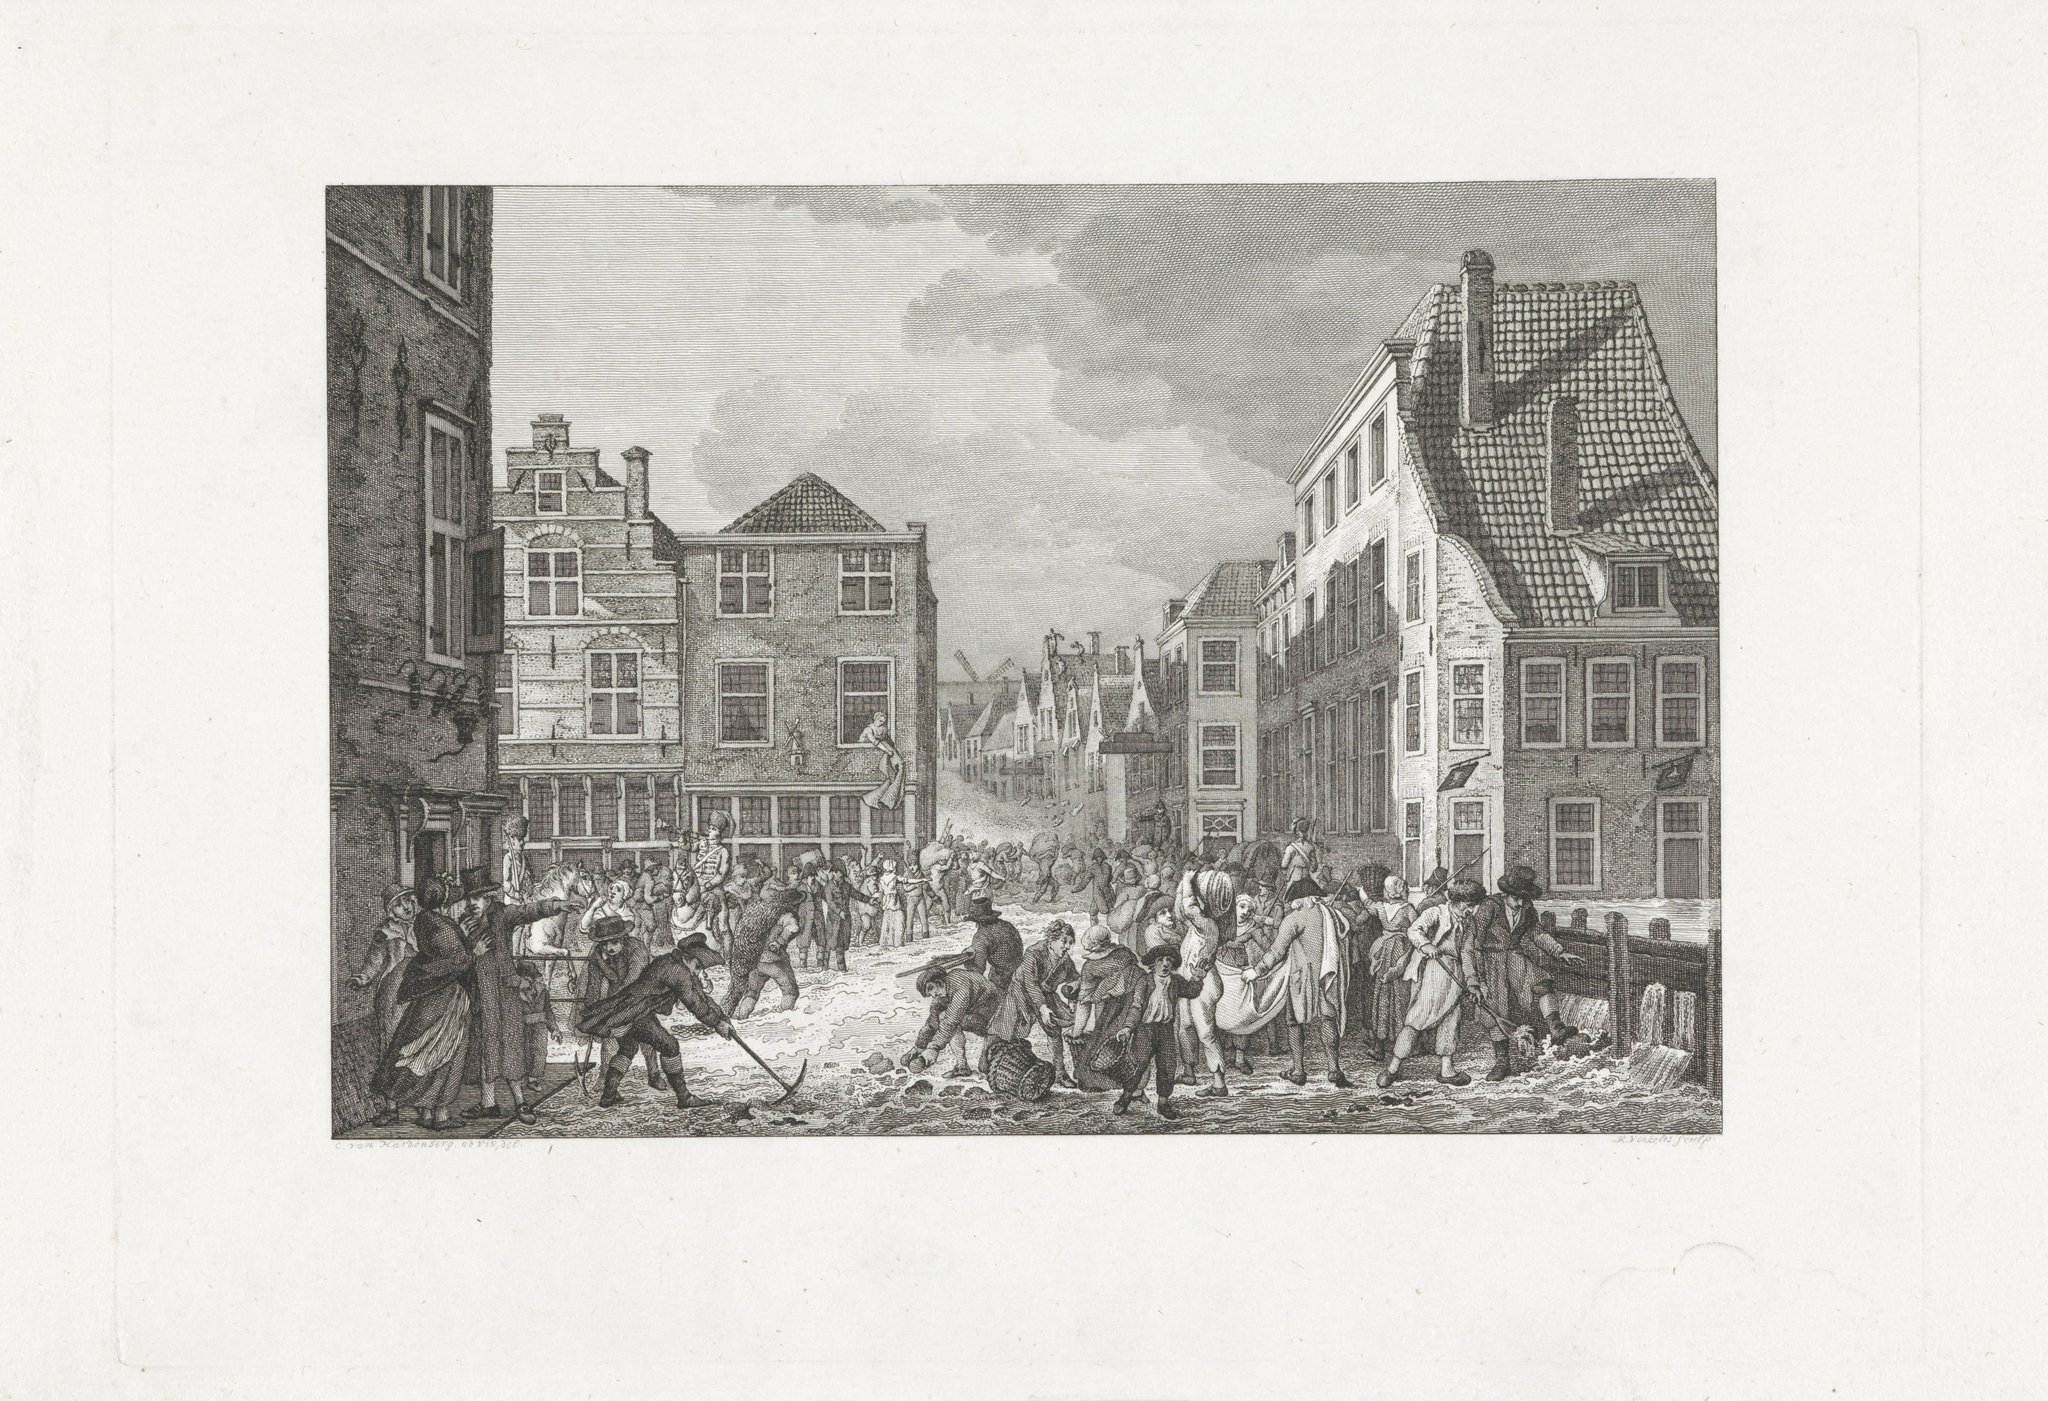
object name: print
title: Overstroming te Gorinchem, 1809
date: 1809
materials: paper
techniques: engraving, etching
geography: gorinchem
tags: dike-break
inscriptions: collector's mark: Lugt 2228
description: Gebruikt als illustratie in: Hendrik Ewijk. Geschiedkundig verslag der dijkbreuken en overstroomingen, langs de rivieren in het Koningrijk Holland, voorgevallen in louwmaand MDCCCIX. 3 dln. Amsterdam: Johannes Allart en Jacobus Ruys, 1809.